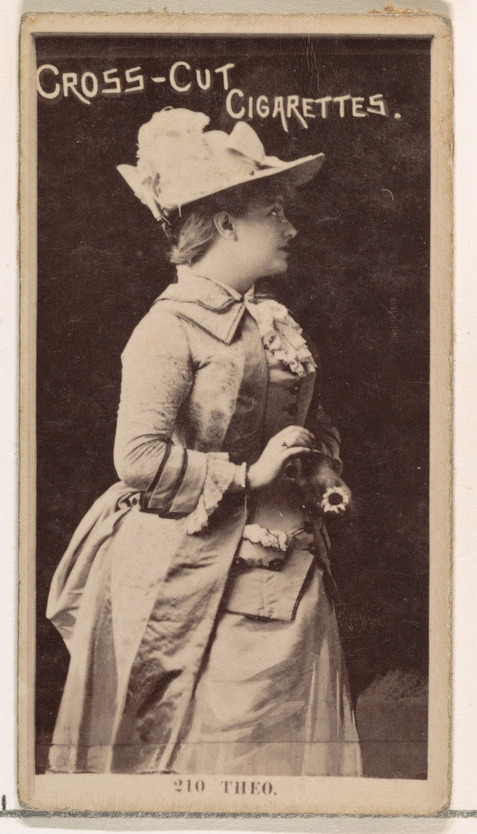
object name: print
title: Card Number 210, Miss Theo, from the Actors and Actresses series (N145-2) issued by Duke Sons & Co. to promote Cross Cut Cigarettes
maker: w. duke, sons & co.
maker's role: publisher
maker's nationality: american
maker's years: 1870-1920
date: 1880-1889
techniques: albumen silver print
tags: women,actresses